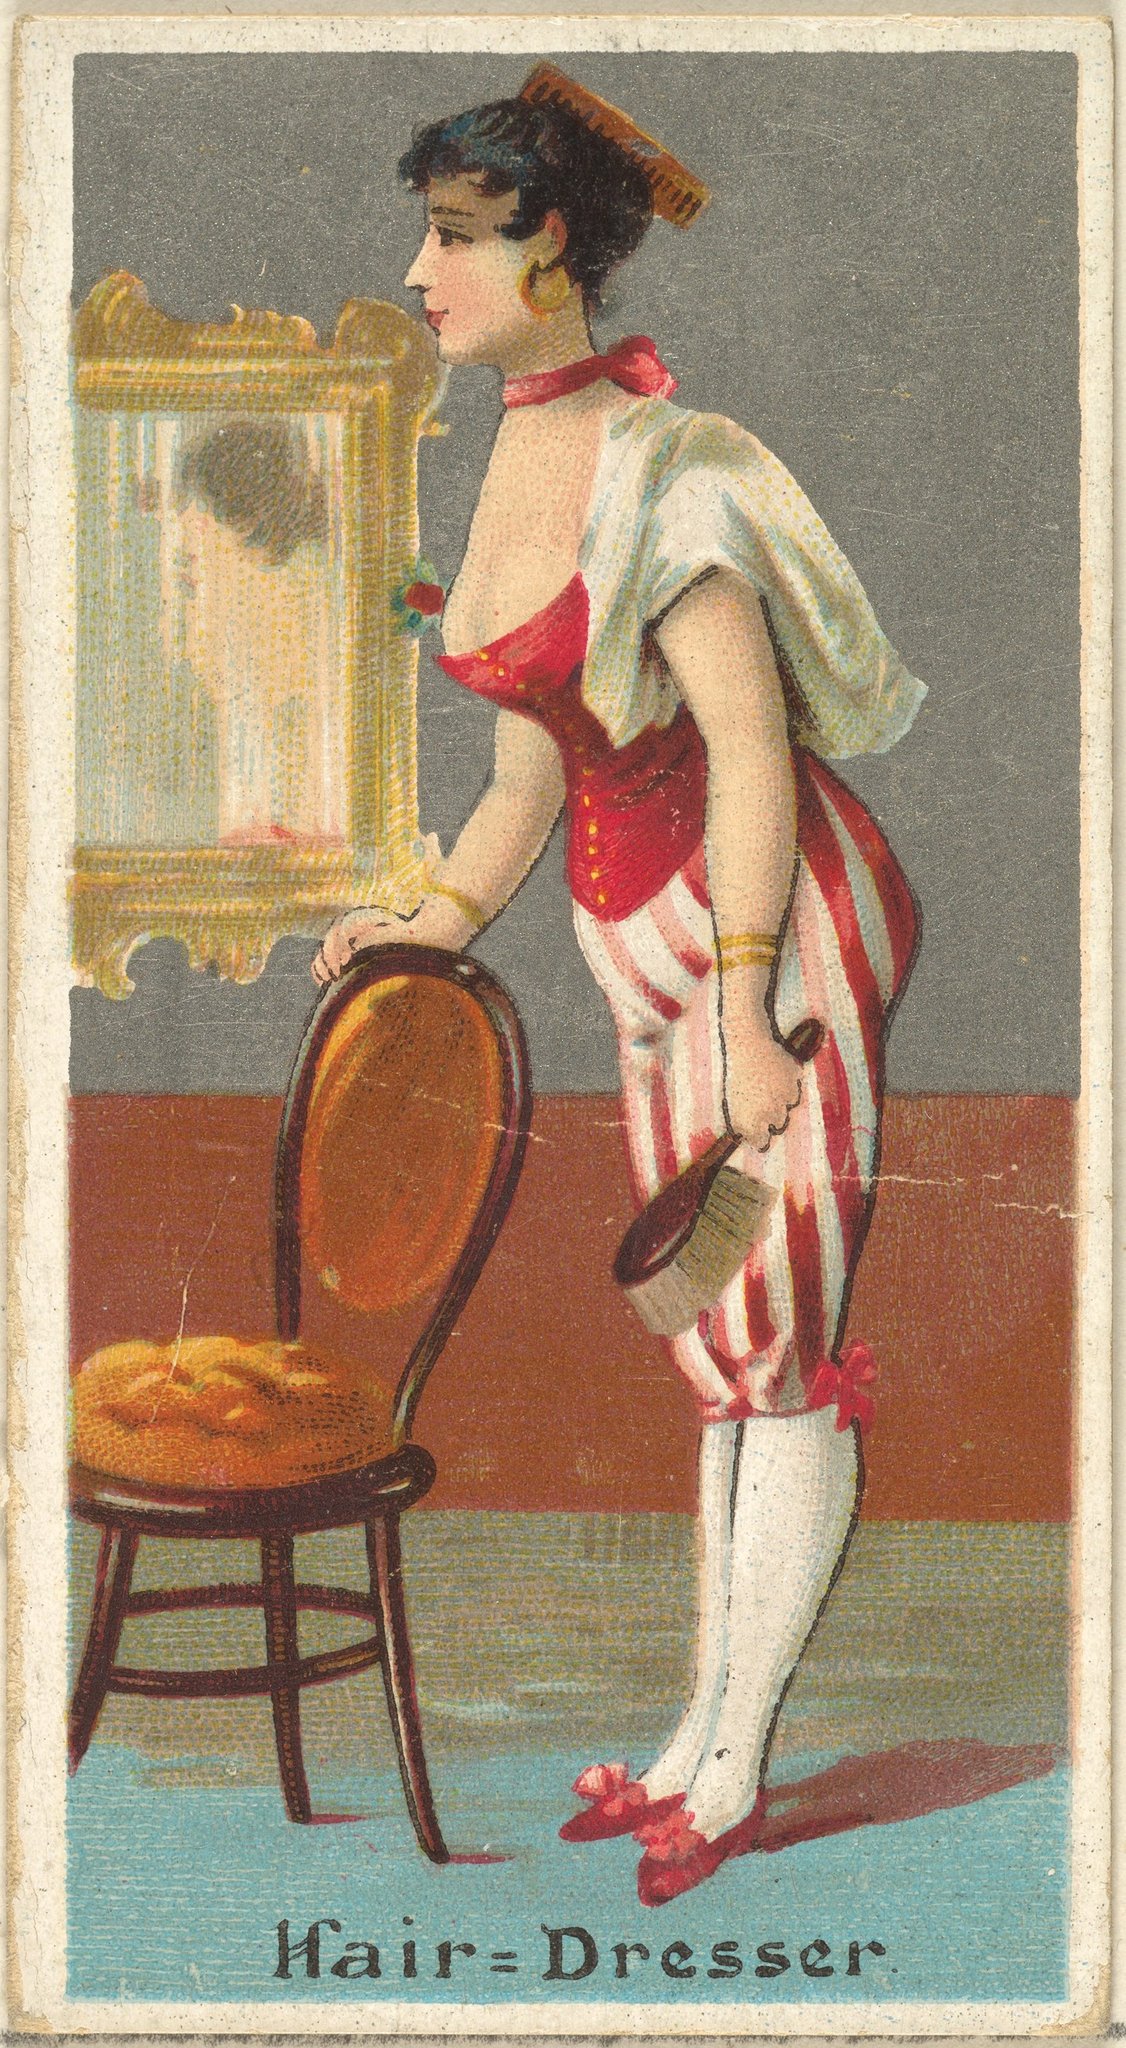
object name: print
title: Hairdresser, from the Occupations for Women series (N166) for Old Judge and Dogs Head Cigarettes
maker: goodwin & company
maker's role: publisher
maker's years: 1850-1950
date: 1887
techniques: color lithograph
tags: profiles,women,dressing,chairs